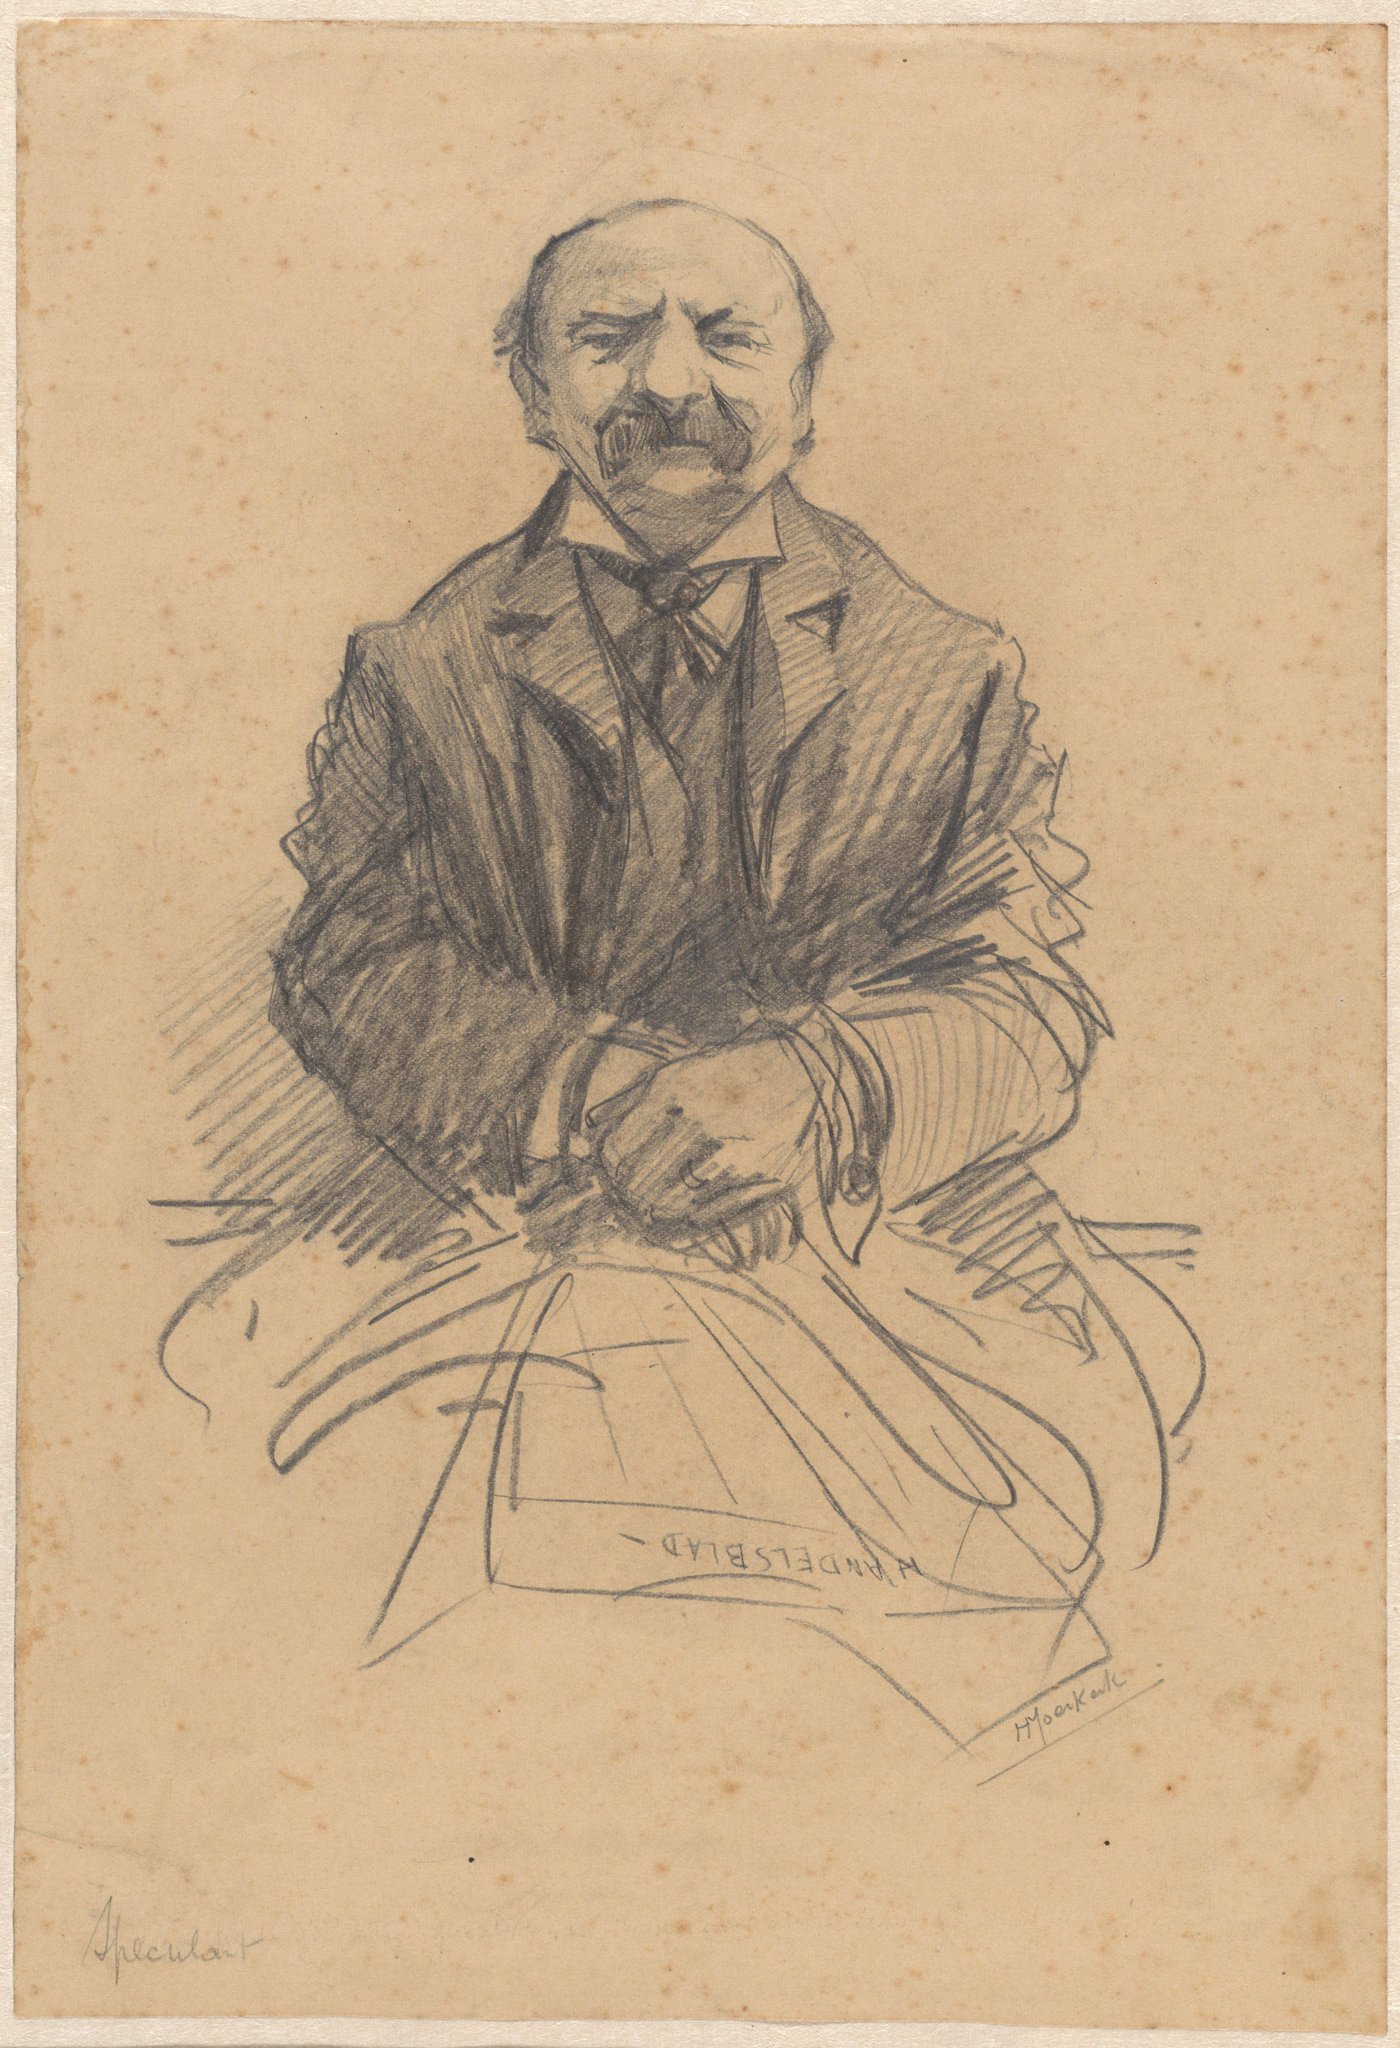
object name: drawing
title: Portret van een speculant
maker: herman moerkerk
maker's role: draughtsman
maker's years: 1879-1949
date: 1889-1944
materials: paper, pencil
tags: speculation in trade and finance, stock-jobbery, caricatures (human types), anonymous historical person portrayed alone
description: Portret van een speculant, op zijn schoot het Handelsblad.